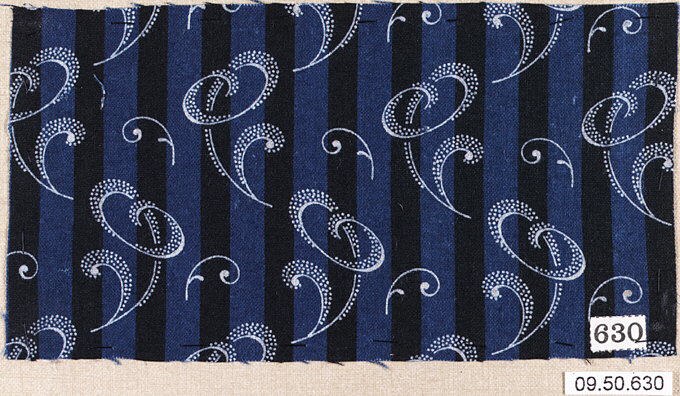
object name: piece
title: Pieces (6)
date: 1801-1900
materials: cotton